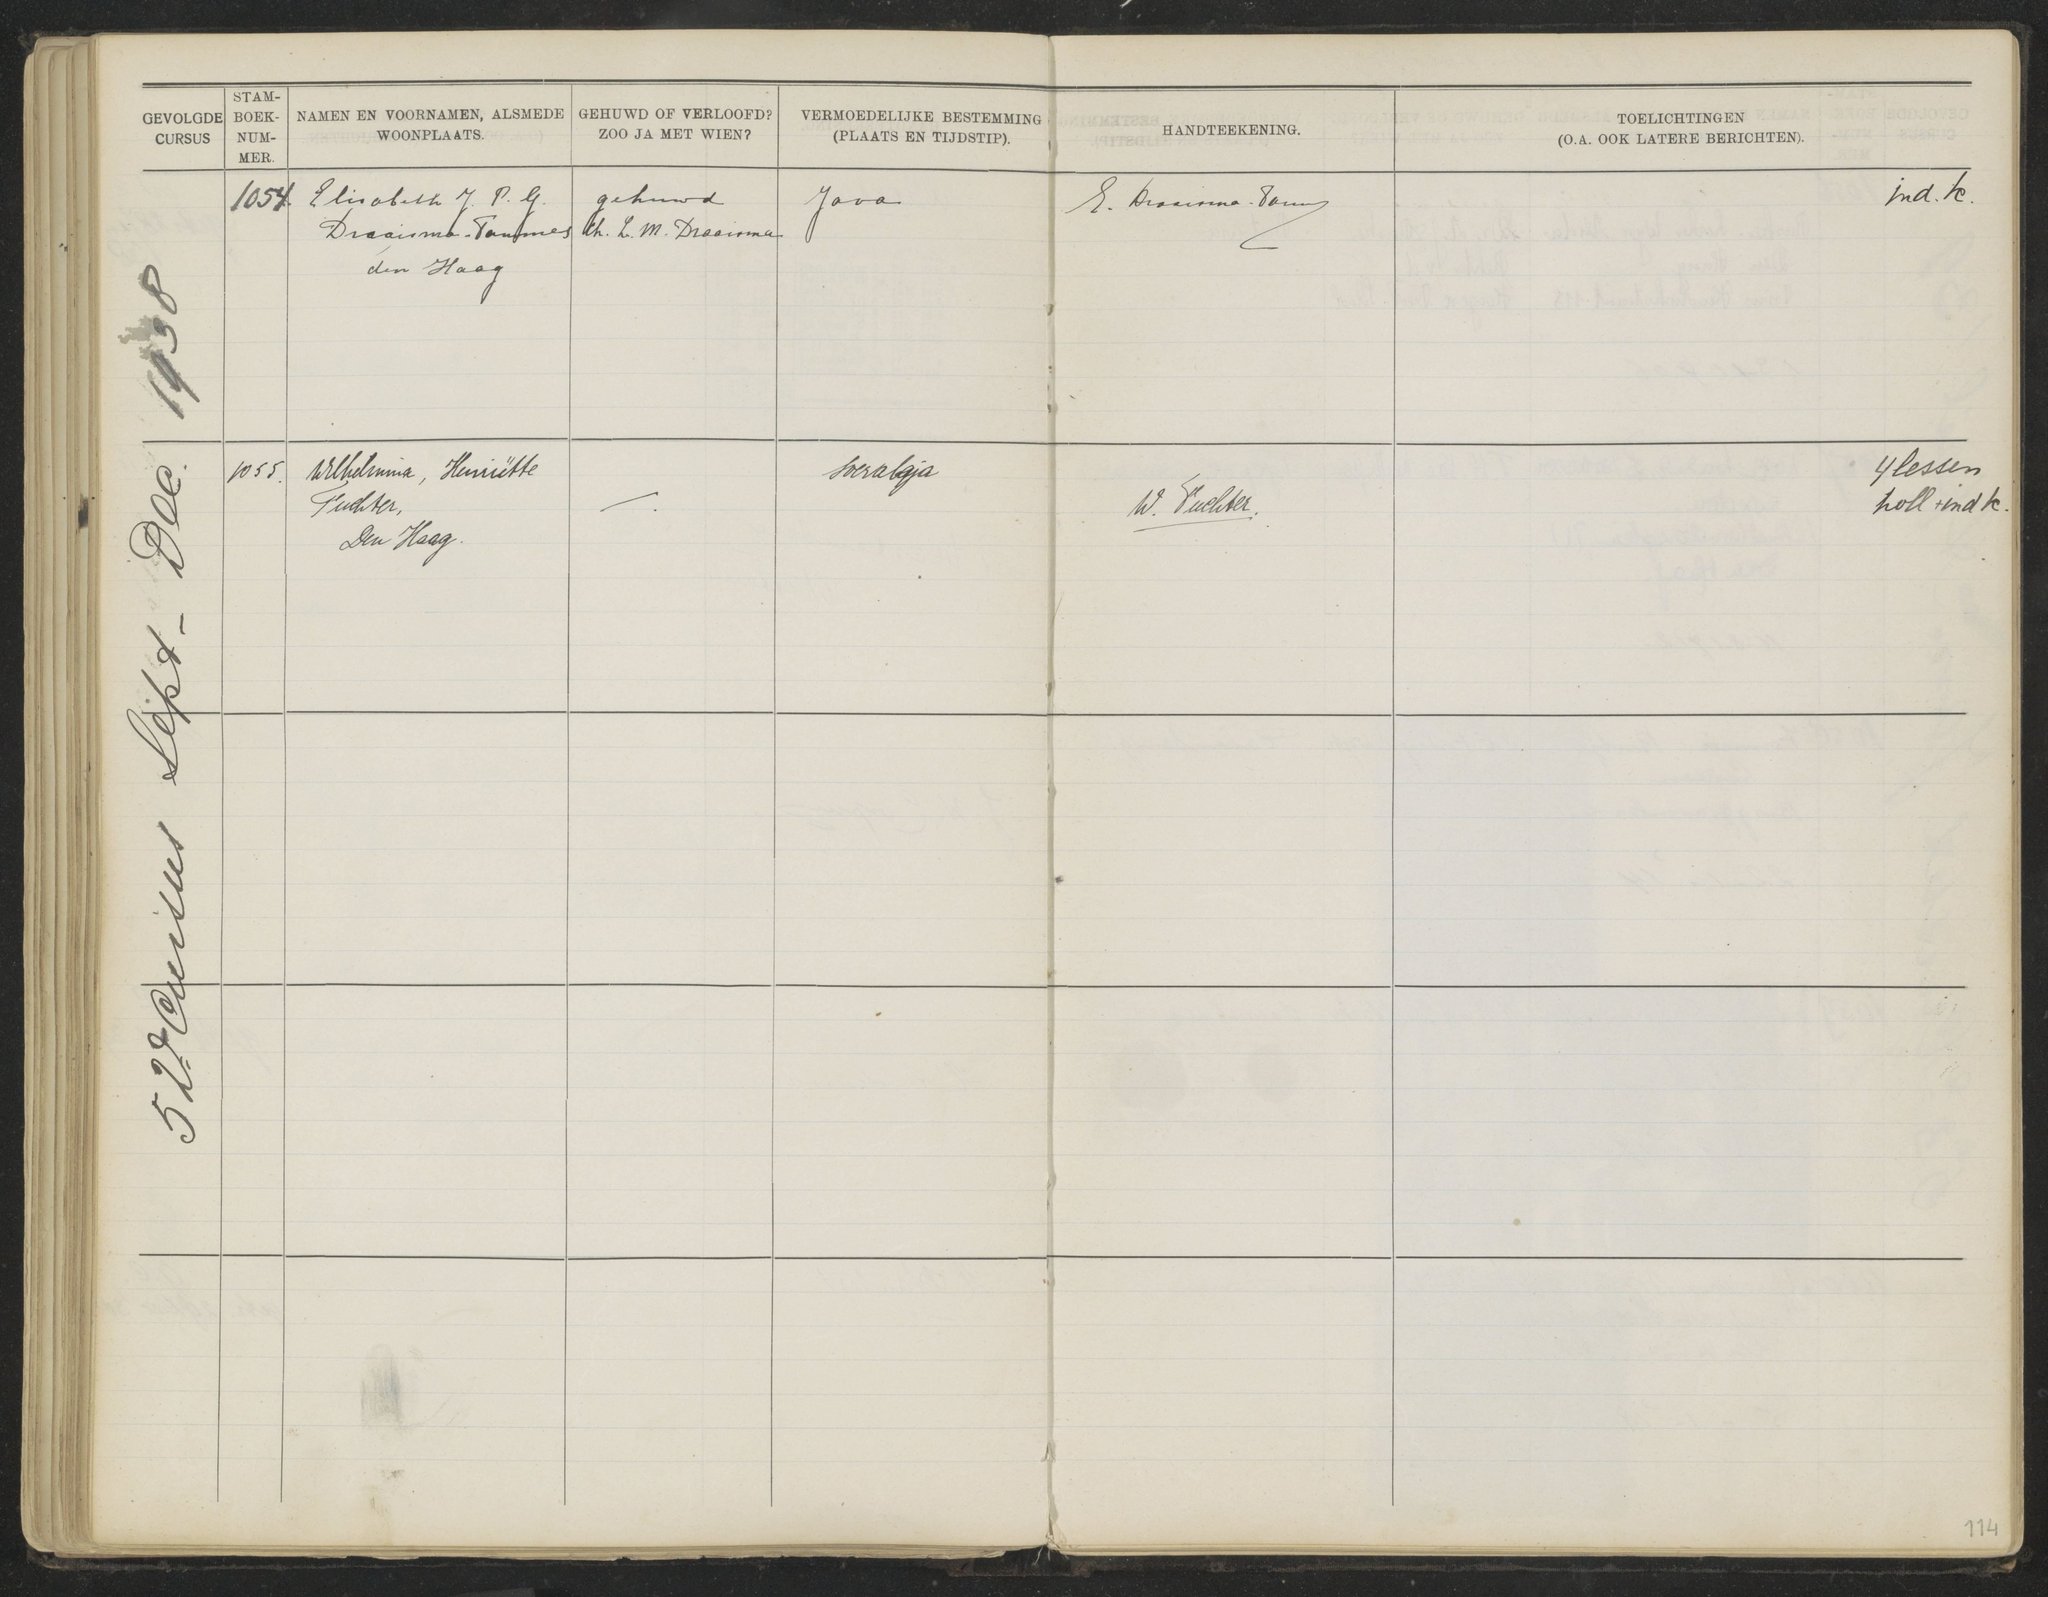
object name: album leaf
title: Blad 114 uit Stamboek van de leerlingen der Koloniale School voor Meisjes en Vrouwen te 's-Gravenhage deel II (1930-1949)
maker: Anonymous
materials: paper, photographic support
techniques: photography, printing, writing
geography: the hague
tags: further education (+ pupil), further education, the hague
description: Twee pagina's met gegevens van de deelnemers aan de 52e driemaandelijkse cursus van september tot december 1938, stamboeknummers 1054 tot en met 1055. Onderdeel van Stamboek van de leerlingen der Koloniale School voor Meisjes en Vrouwen te 's-Gravenhage deel II (1930-1949).